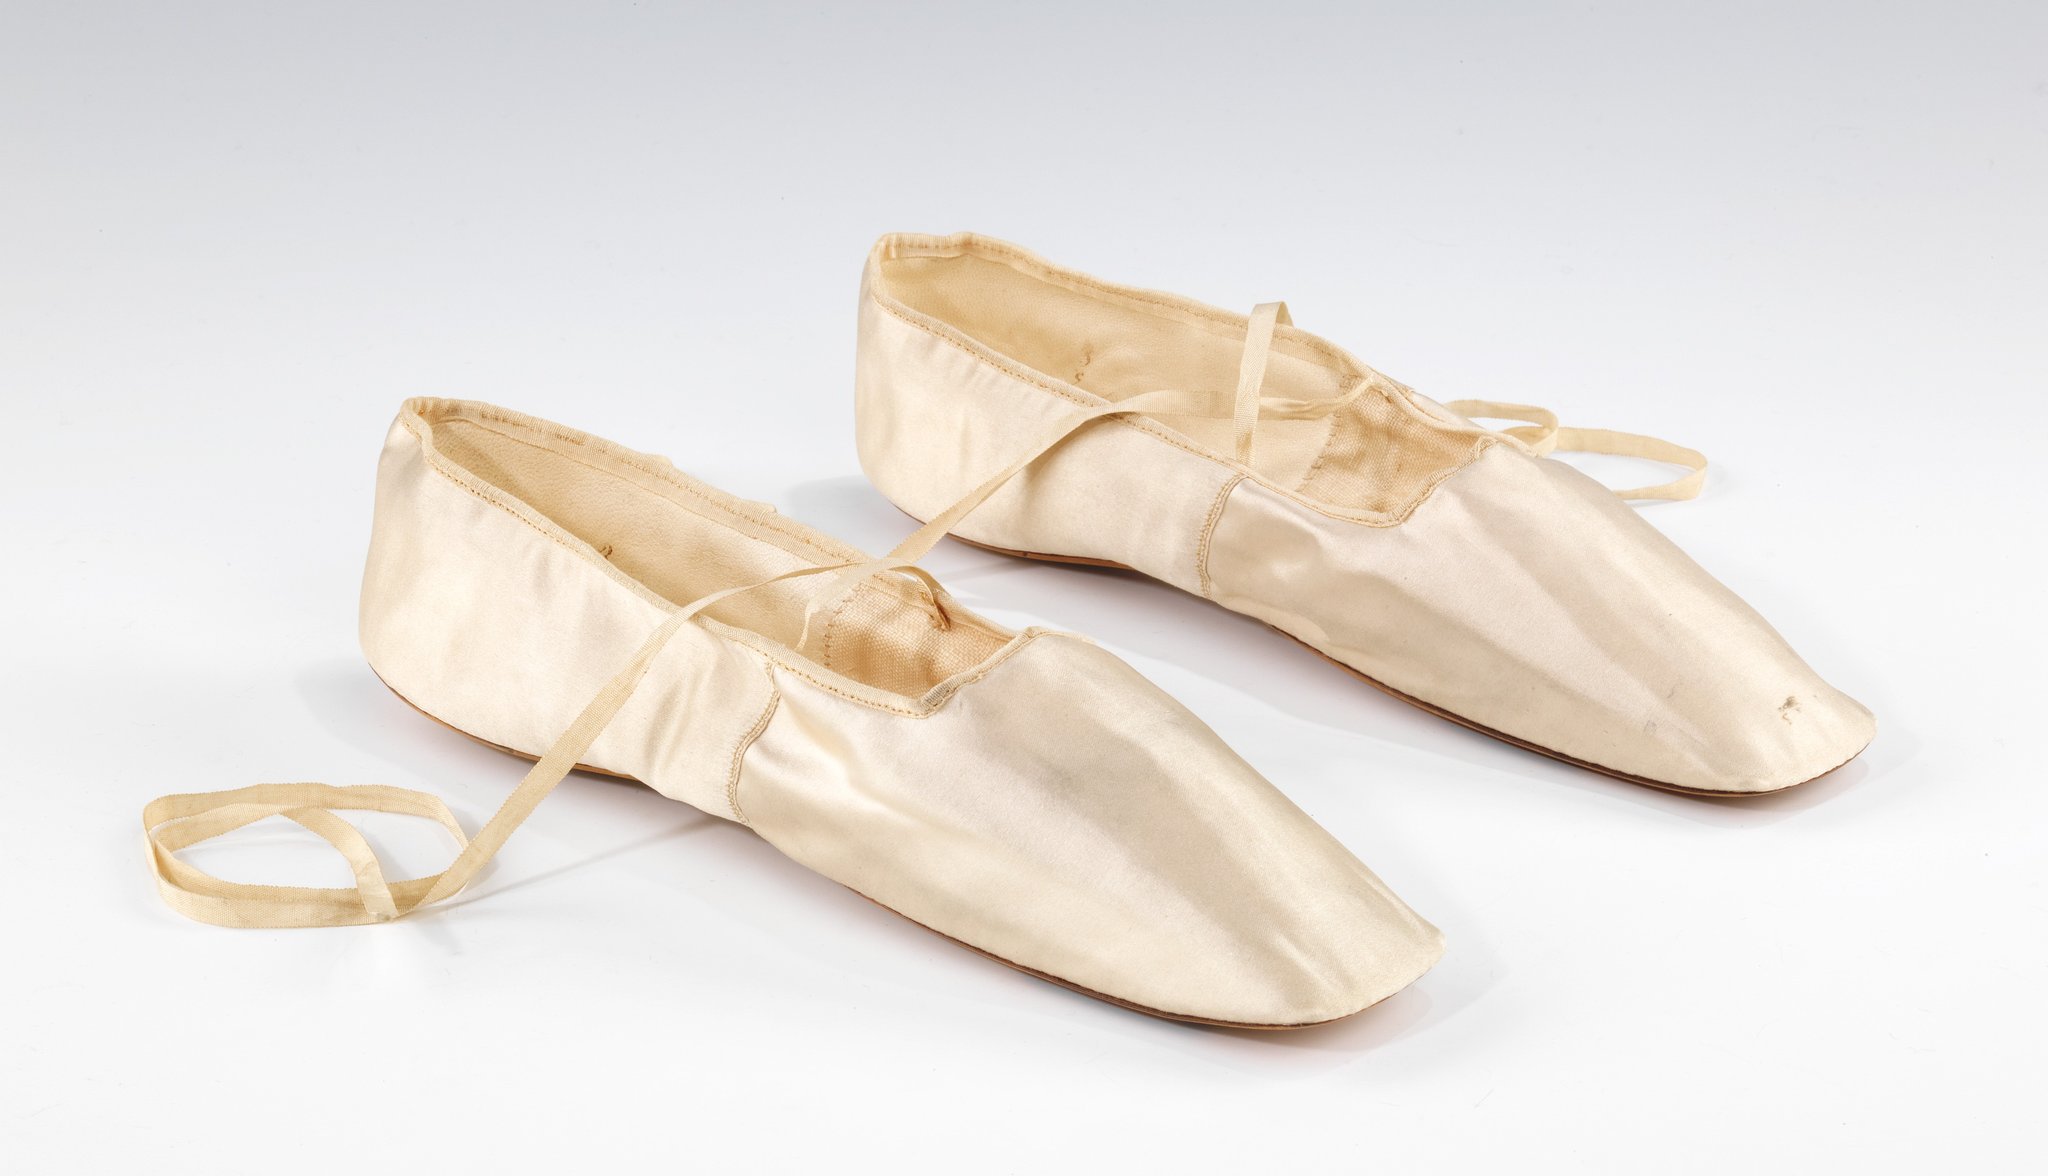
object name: wedding slipper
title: Wedding slippers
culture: american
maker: c. middleton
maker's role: designer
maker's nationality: american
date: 1844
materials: silk